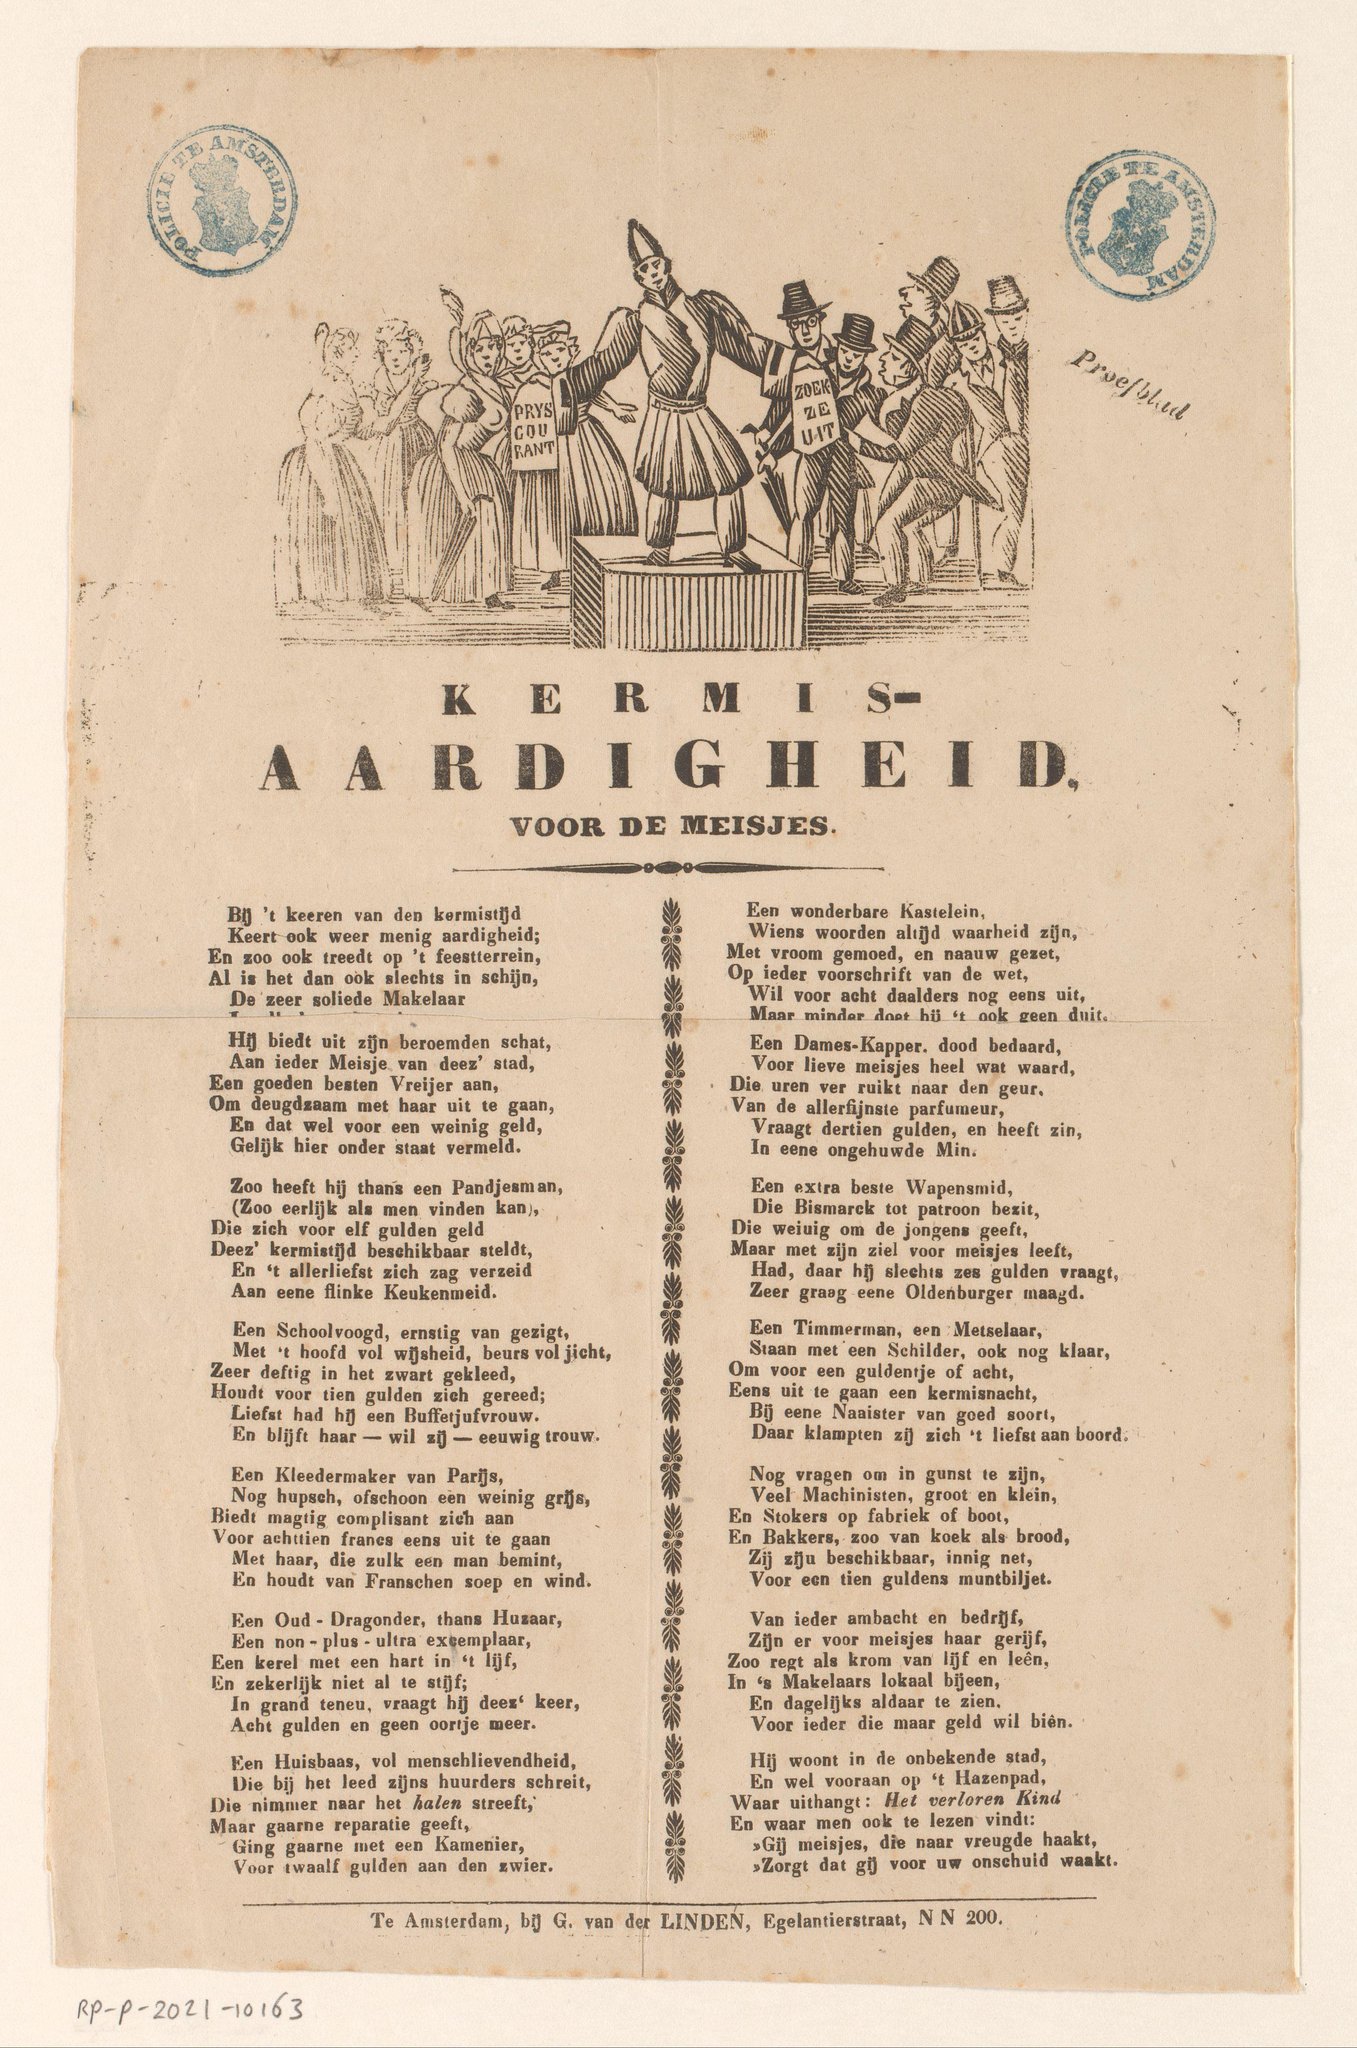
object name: cartoon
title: Man veilt afspraakjes voor tijdens de kermis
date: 1864-1875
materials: paper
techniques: letterpress printing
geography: amsterdam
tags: pleasure fair and circus, lovers; courting, flirting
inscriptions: collector's mark: Lugt 2228, stamp: ‘Politie te Amsterdam’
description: Deze prent is vermoedelijk ter goedkeuring voorgelegd aan de politie Amsterdam, te zien aan de stempels en het woord 'Proefblad' rechtsboven. Op een exemplaar in het Stadsarchief Amsterdam ontbreekt het woord 'Proefblad' op de prent, waarschijnlijk is de prent dus goedgekeurd en uitgegeven. Een andere mogelijkheid is dat de prent werd gecontroleerd vanwege ongeregeldheden op de kermis. De Amsterdamse kermis werd in 1876 verboden.